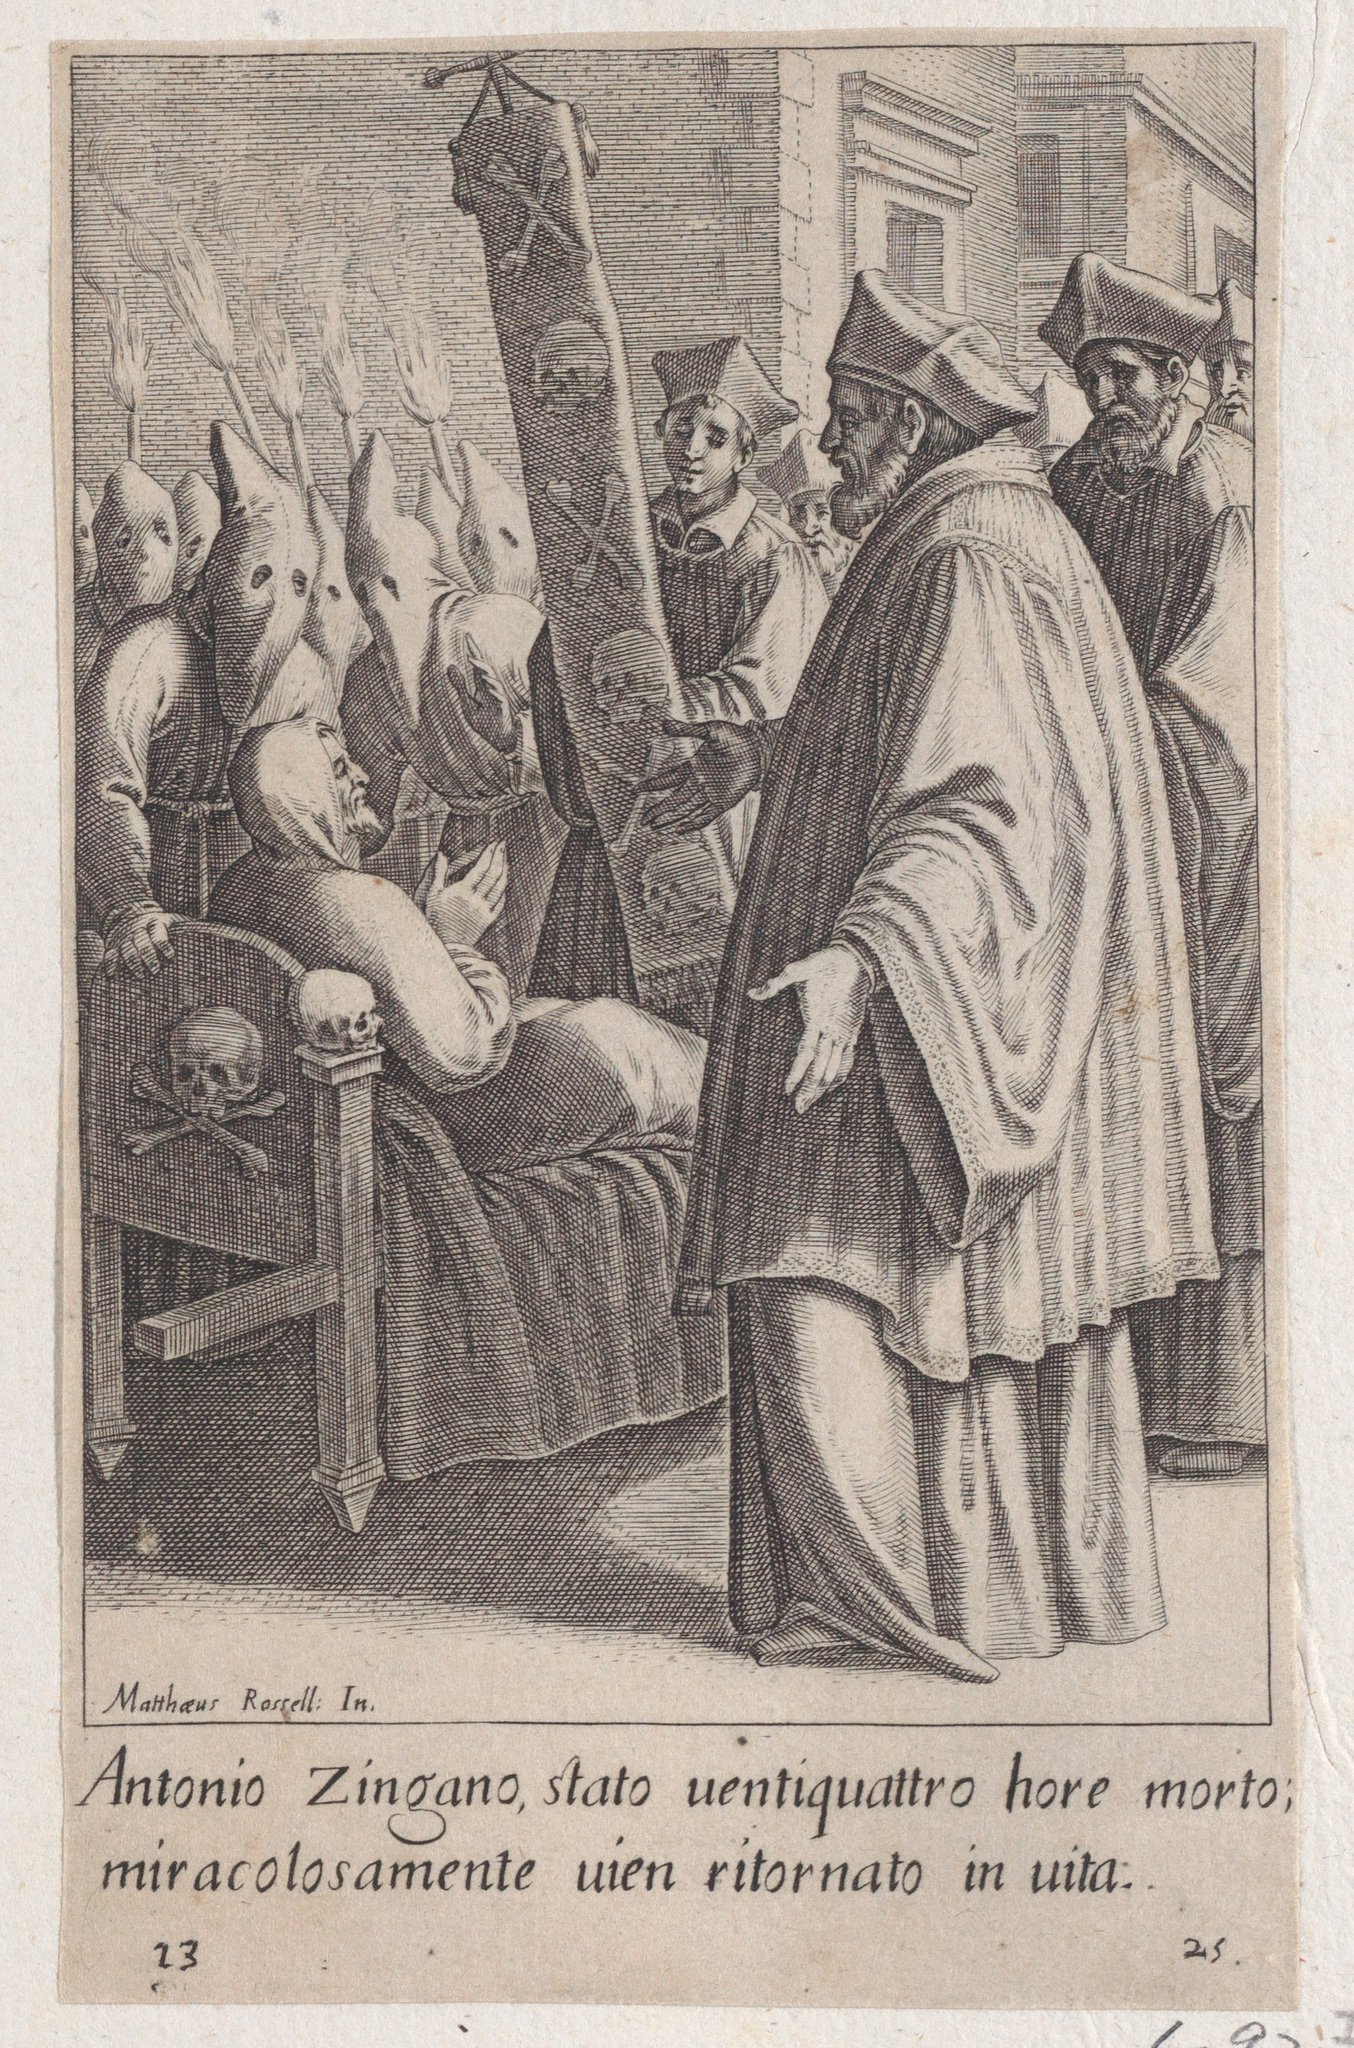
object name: print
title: Antonio Zingano, from Scelta d'Alcuni Miracoli e Grazie della Santissima Nunziata di Firenze (Selection of Some Miracles and Graces that Occurred in the Church of the Annunziata in Florence)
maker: jacques callot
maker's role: artist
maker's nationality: french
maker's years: 1592-1635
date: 1611-1619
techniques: engraving